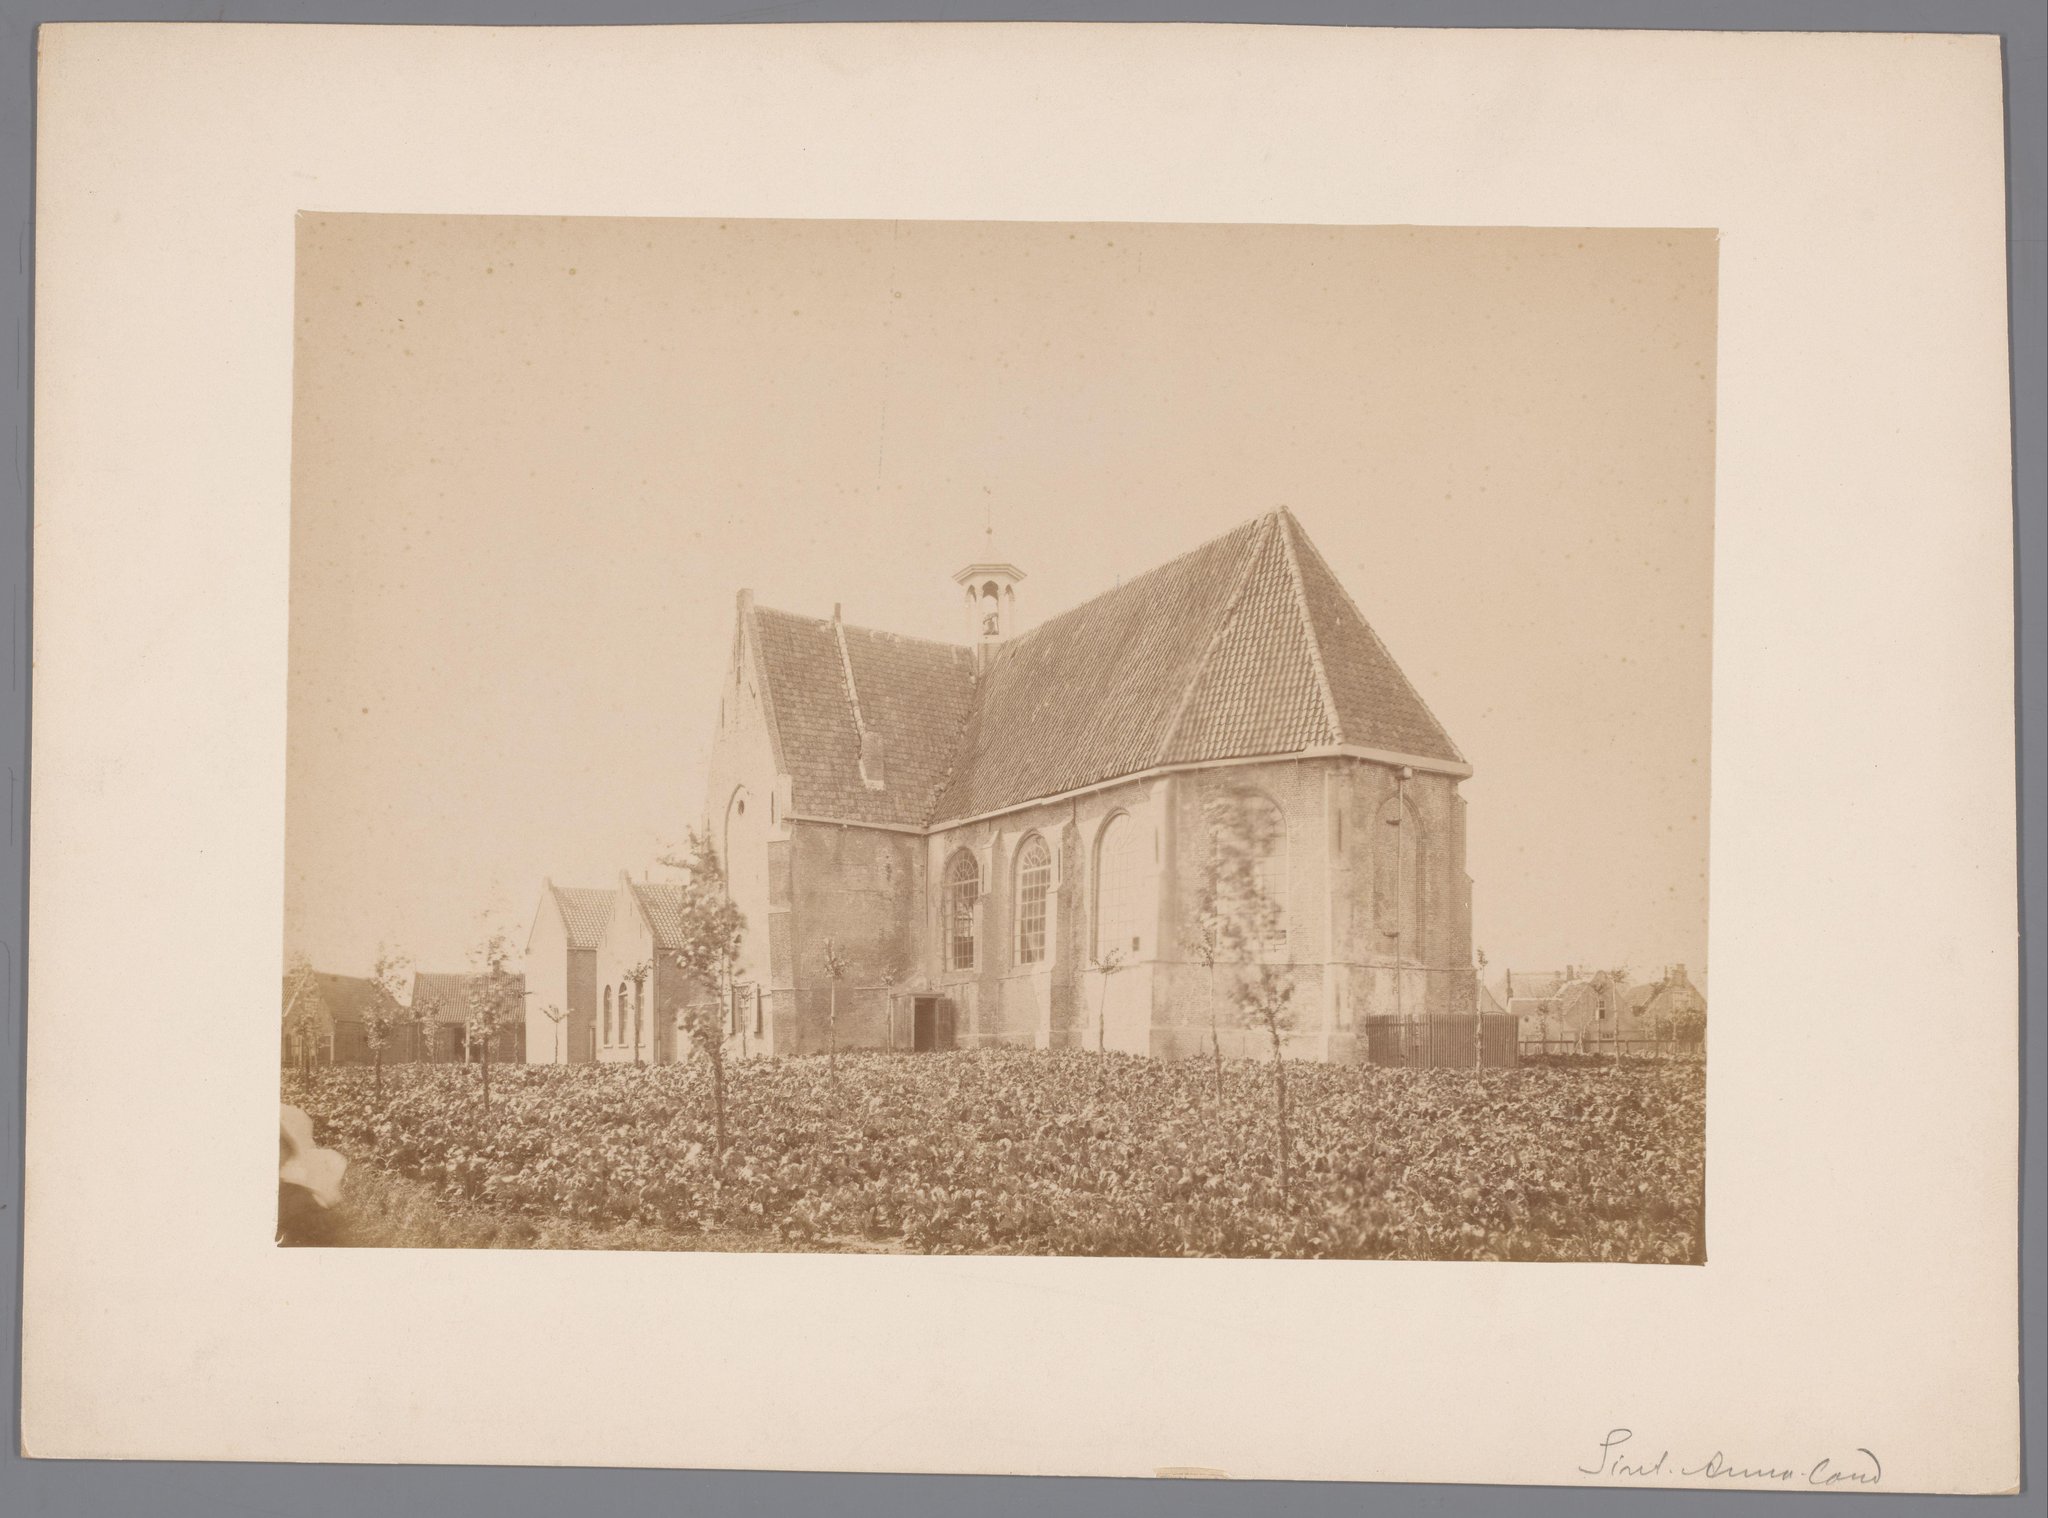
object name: photograph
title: Gezicht op de Hervormde Kerk te Sint-Annaland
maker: anoniem (monumentenzorg)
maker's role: fotograaf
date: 1893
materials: cardboard, photographic support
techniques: albumen print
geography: sint annaland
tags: church (exterior)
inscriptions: annotation: ‘Sint Anna Land’, annotation: ‘St. Annaland (Zeeland)/ Kerk v/d Ned. Herv. gemeente/ Juli 1893’